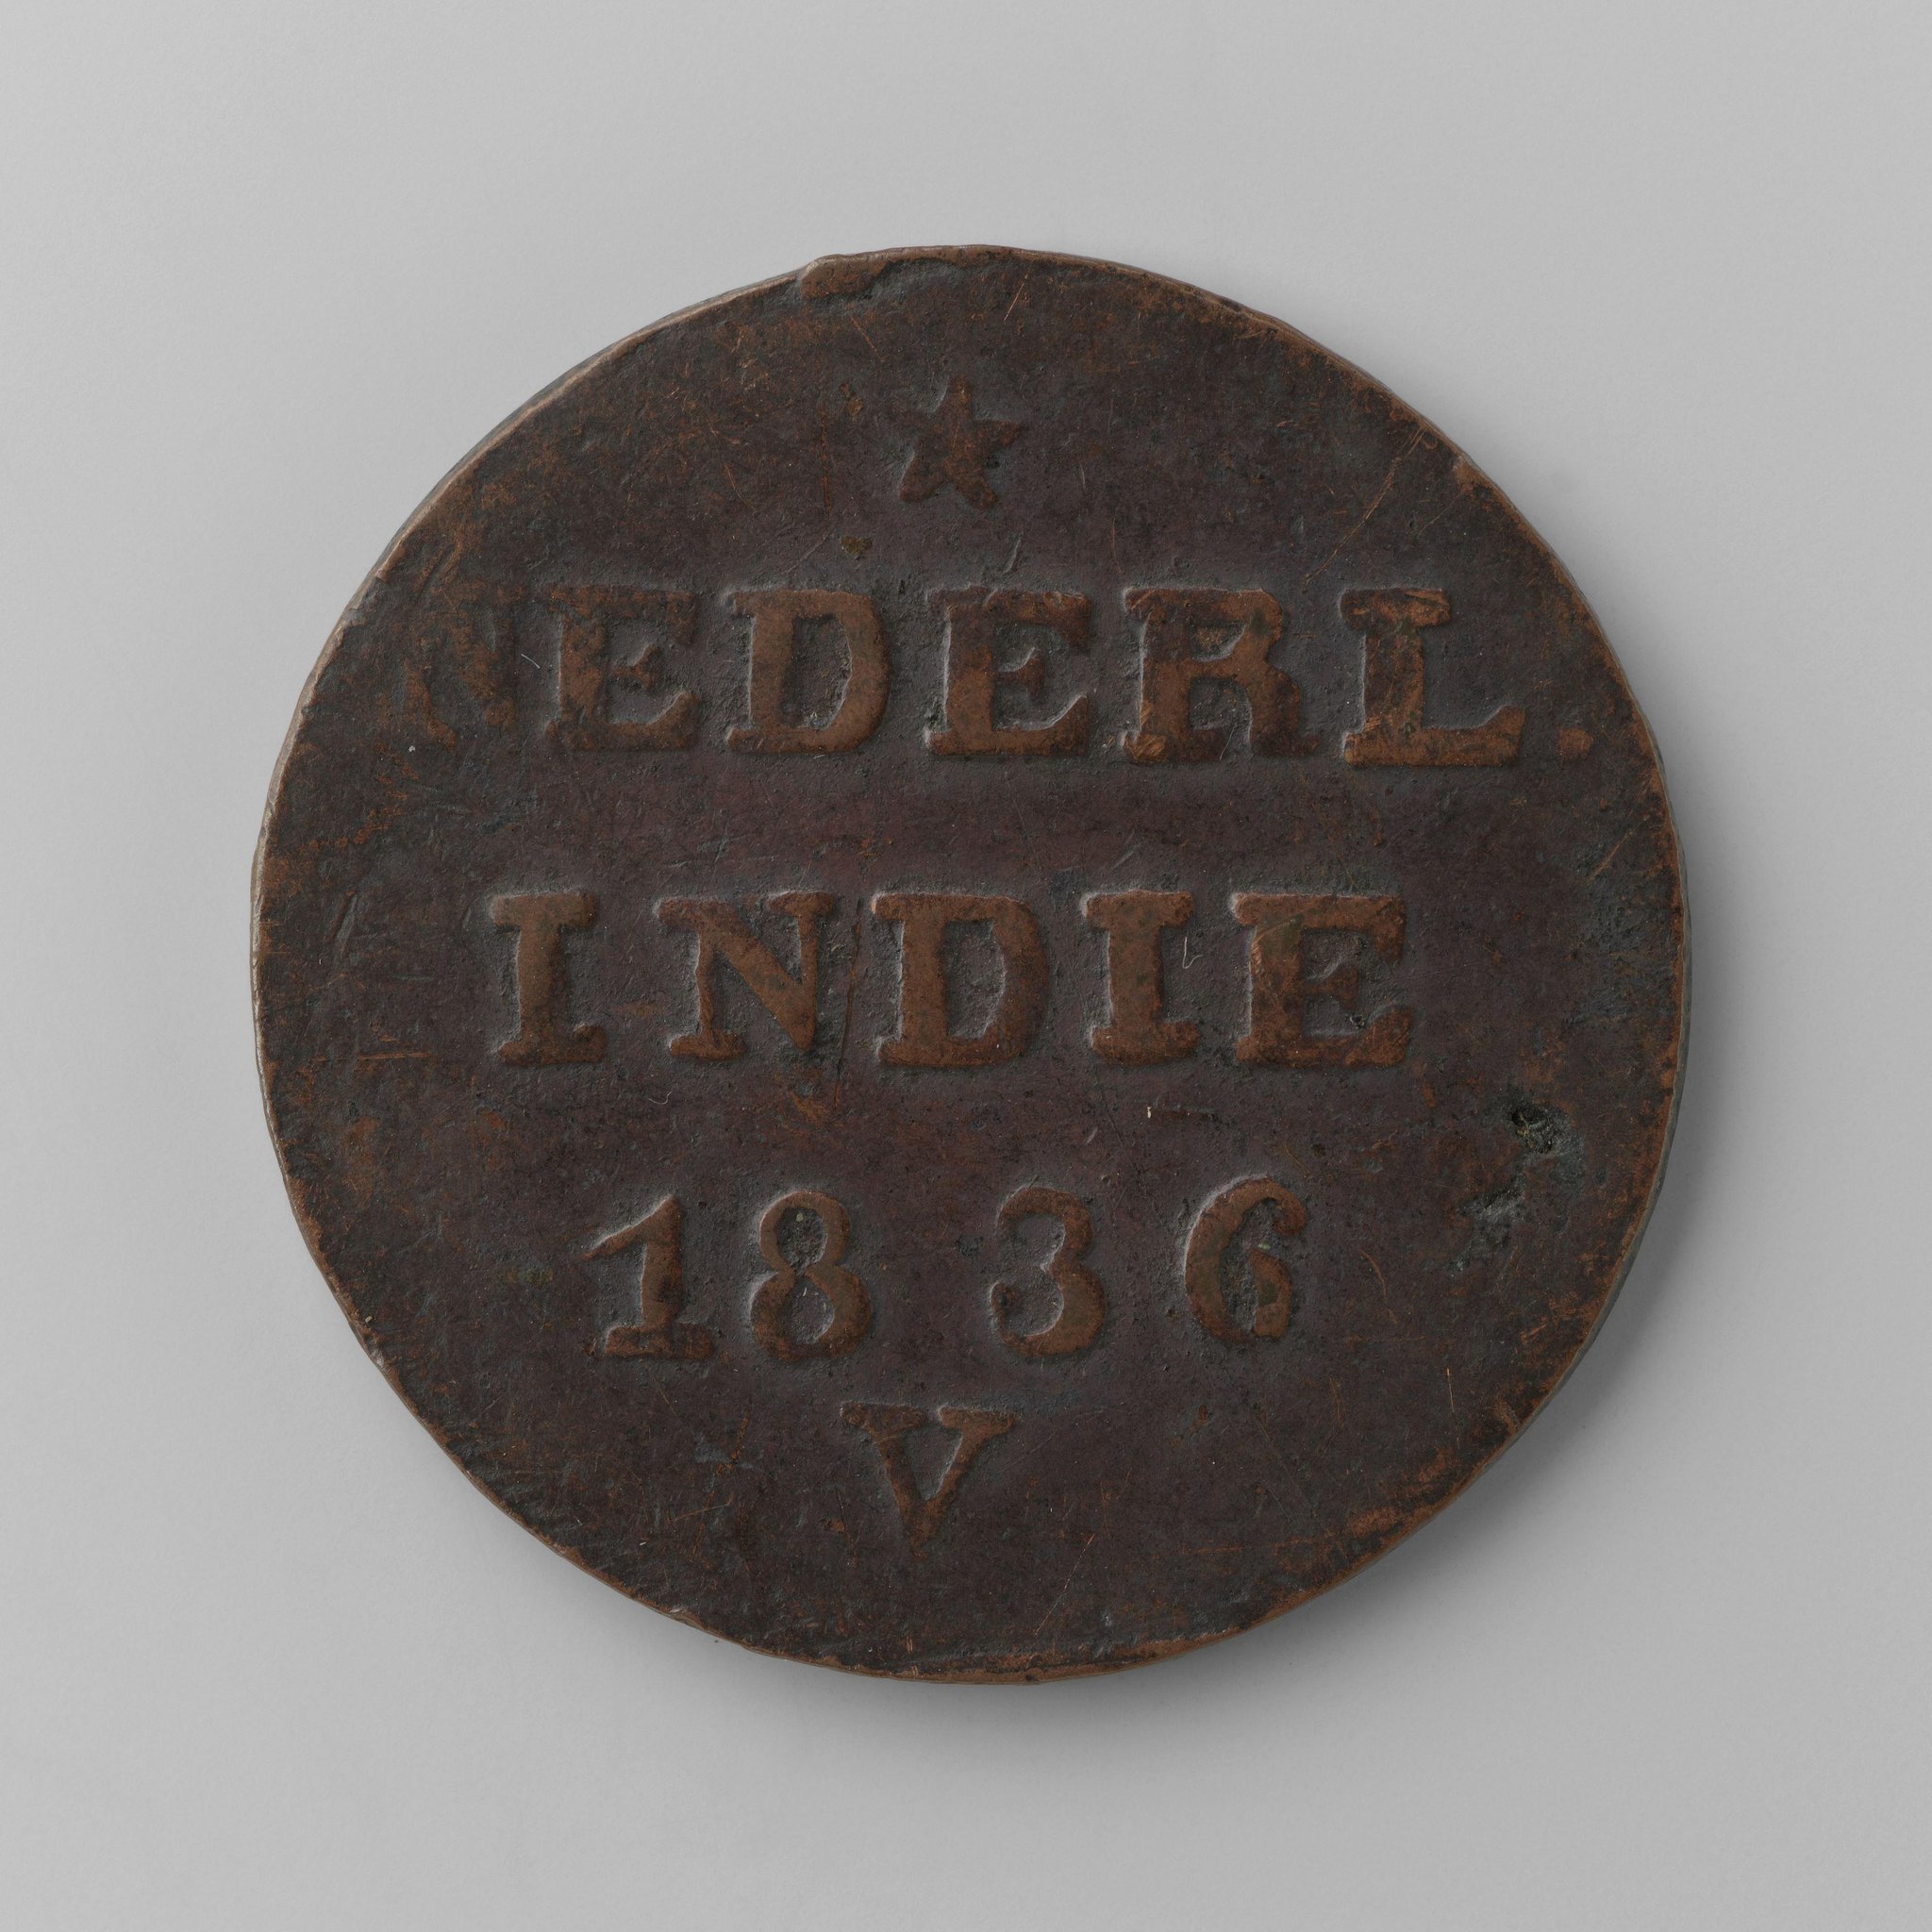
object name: coin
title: Nederlands Indië, 2 cent,1836 V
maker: william i of the netherlands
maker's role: koning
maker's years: 1772-1843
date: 1836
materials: copper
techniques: striking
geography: surabaya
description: Koperen munt. Voorzijde: tussen waarde-aanduiding 2 CT. gekroond rijkswapenschild. Keerzijde: tweeregelig opschrift, waarboven muntteken en waaronder jaartal. Daaronder letter V [=muntmeester De Vogel]. Gladde rand.